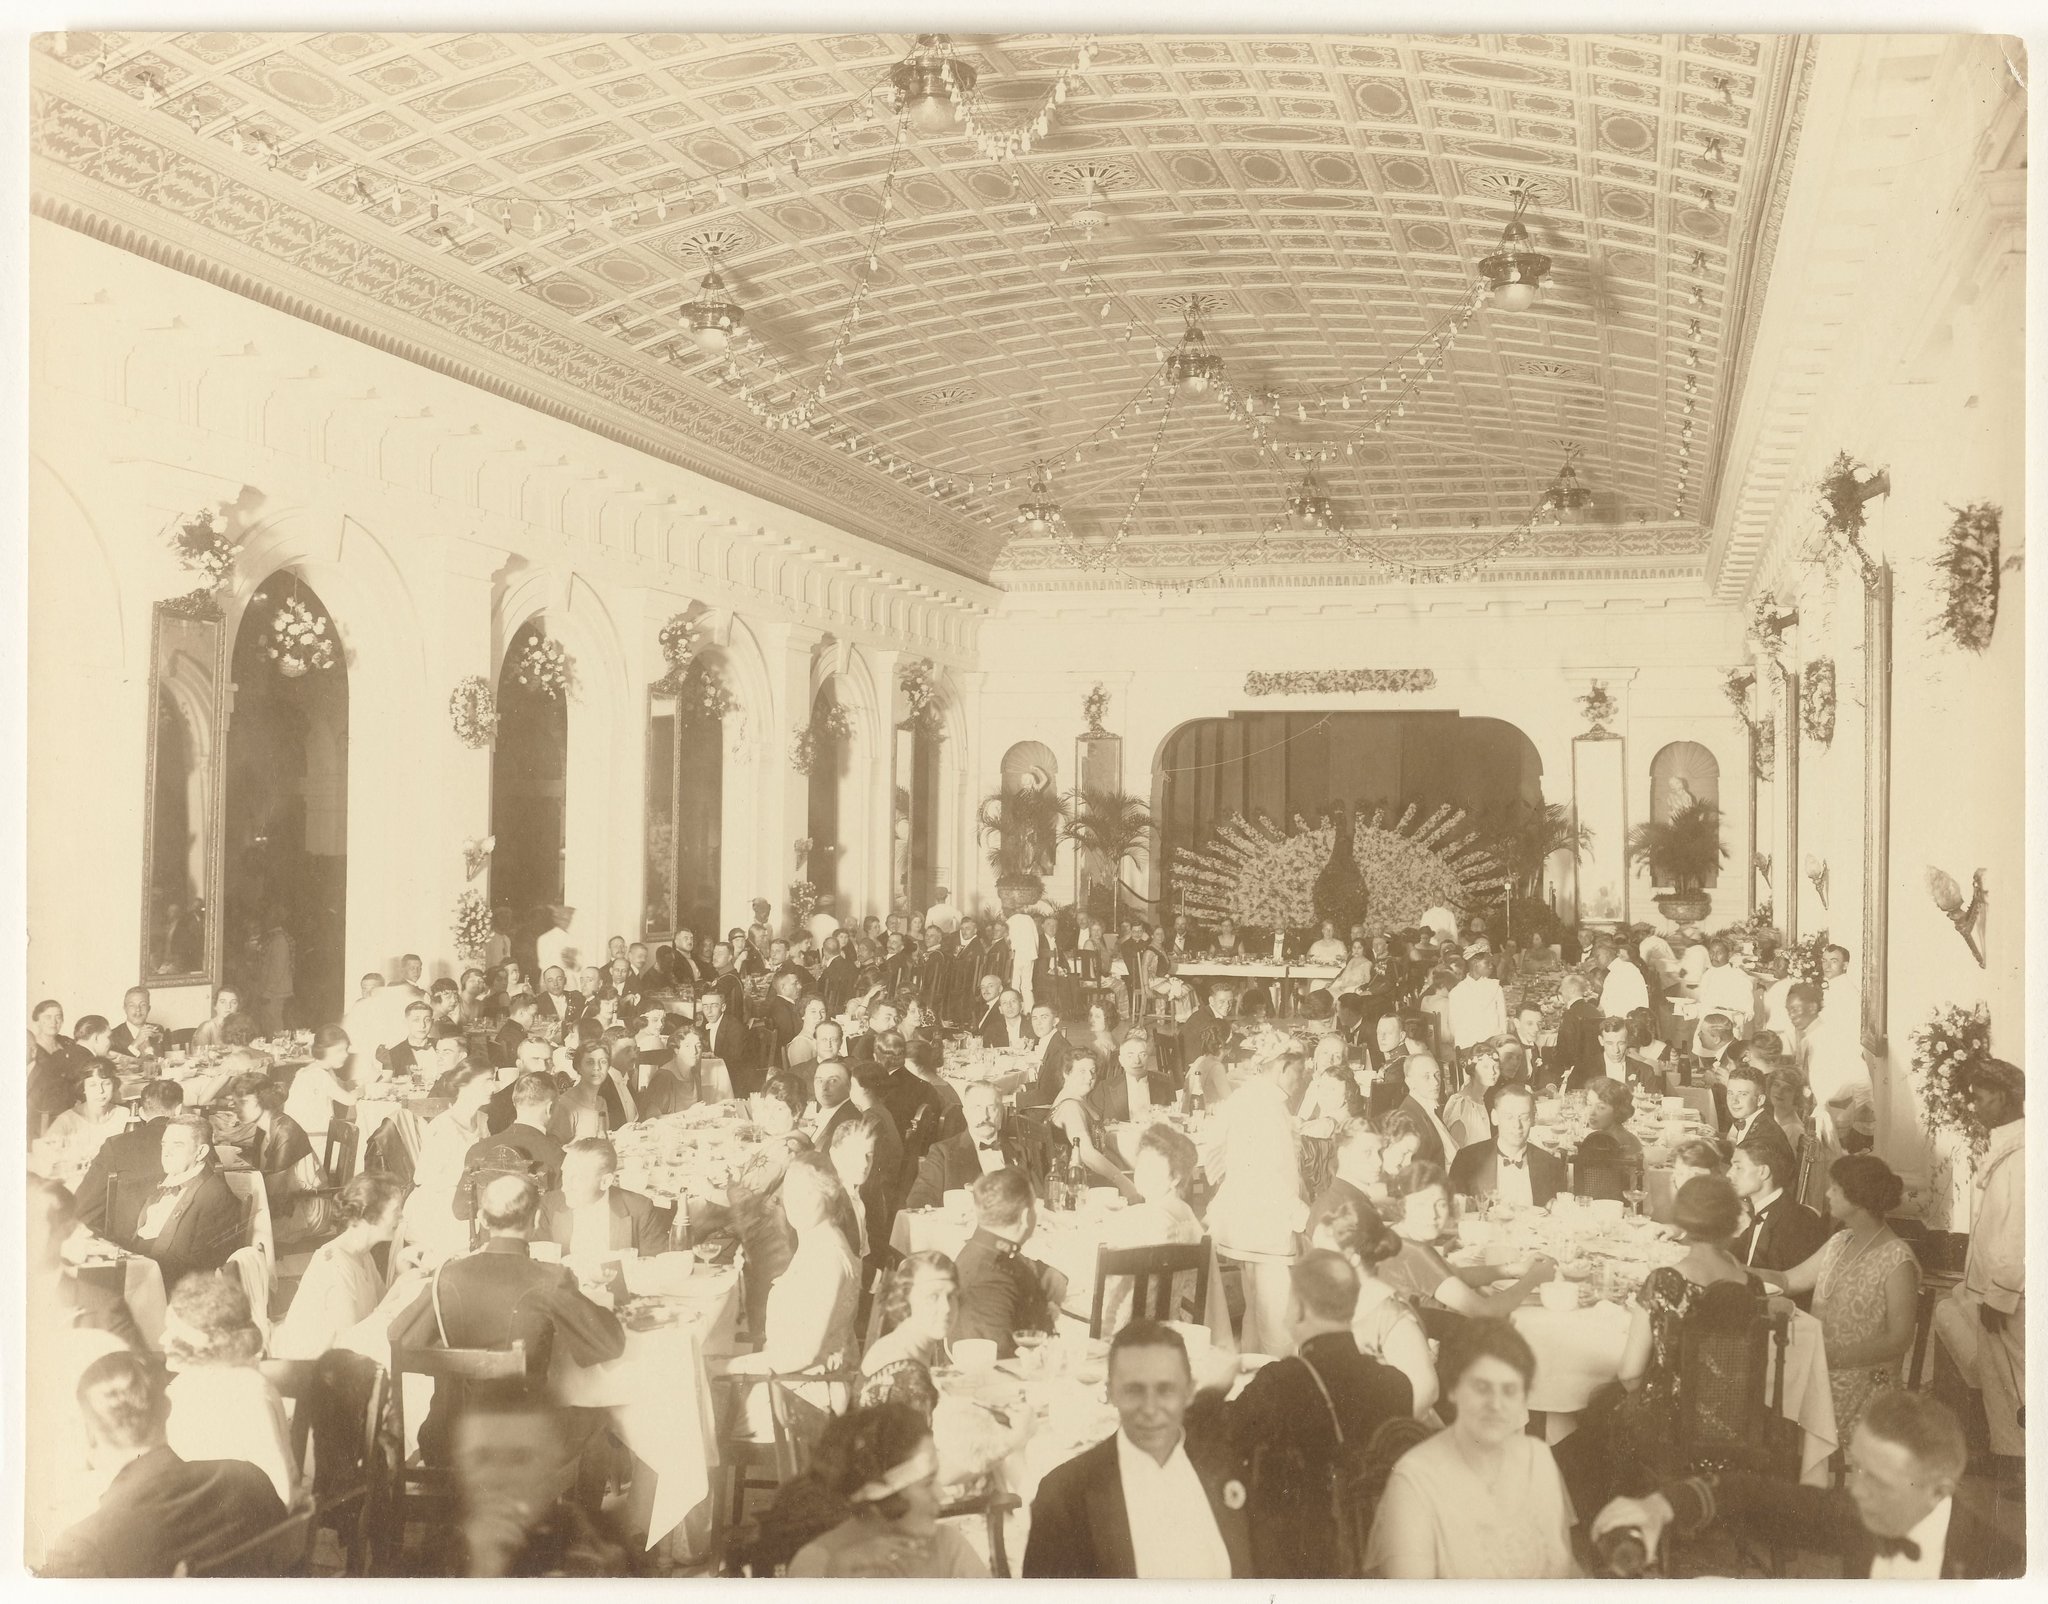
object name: photograph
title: Het regeringsjubileum van koningin Wilhelmina in sociëteit Concordia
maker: Anonymous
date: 1923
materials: photographic support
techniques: photography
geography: dutch east indies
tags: the hague, print maker, wilhelmina of the netherlands, commemoration, jubilee, dutch east indies, the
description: Viering van het regeringsjubileum van koningin Wilhelmina in sociëteit Concordia.